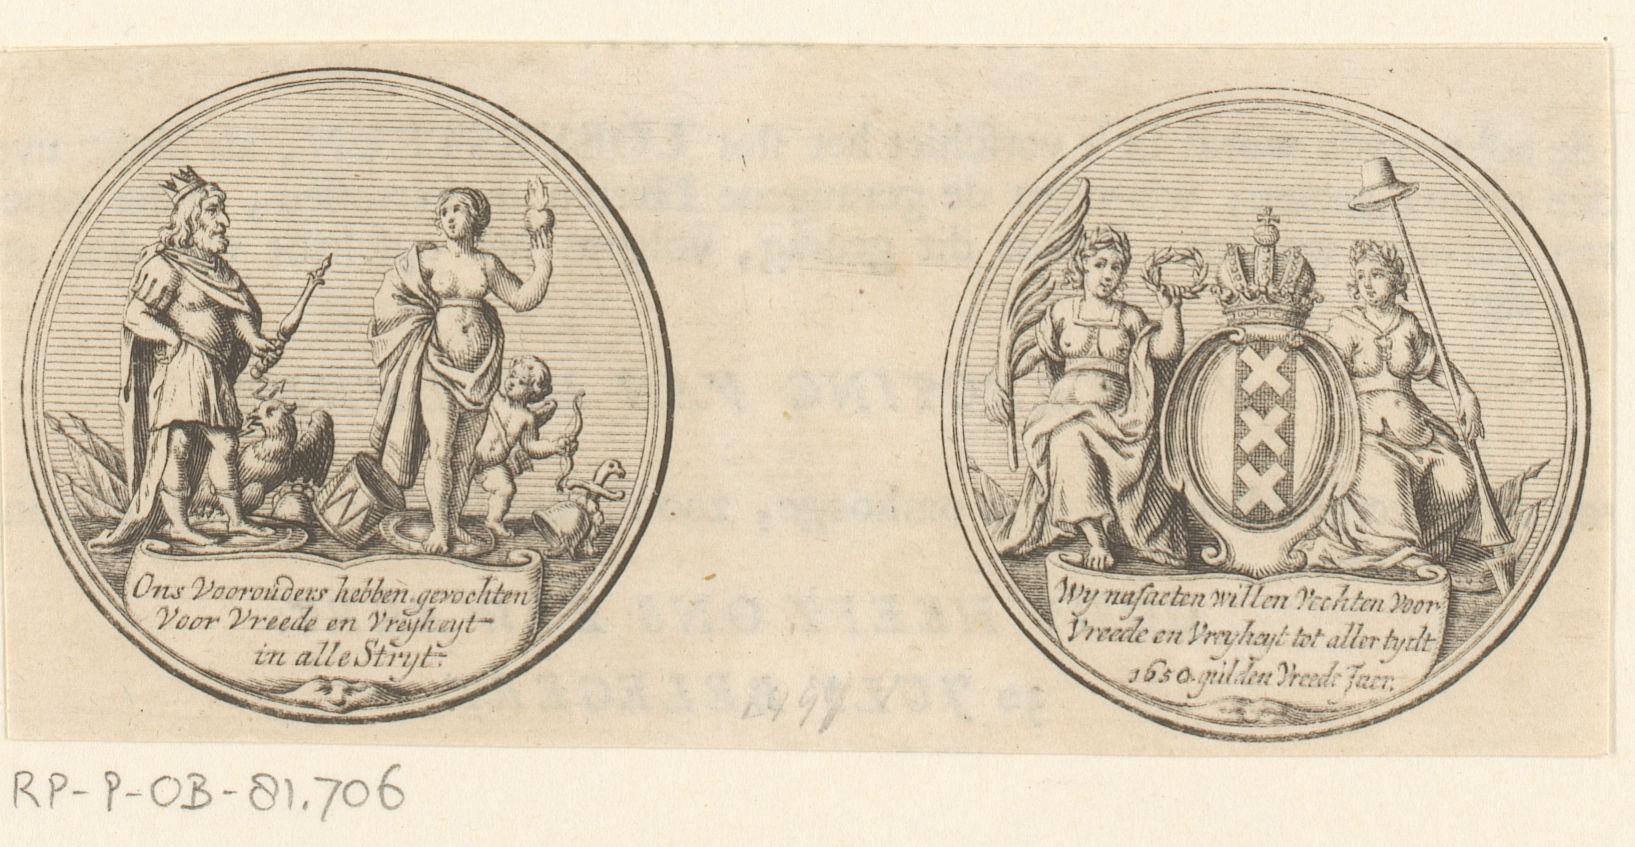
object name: print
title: Penning op het beleg van Amsterdam door Willem II, 1650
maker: Anonymous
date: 1724-1726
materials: paper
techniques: etching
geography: northern netherlands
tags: william ii (prince of orange), medal (considered as a piece of sculpture, regardless of its specific function), amsterdam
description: Illustratie afkomstig uit: Gerard van Loon, Beschryving der Nederlandsche Historipenningen... sedert de overdracht der heerschappye van Keyzer Karel den Vden op Koning Philips... tot... den Uytrechtschen vreede, 4 dln, C. van Lom, Den Haag 1723-1731, dl. II (1726), p. 349.